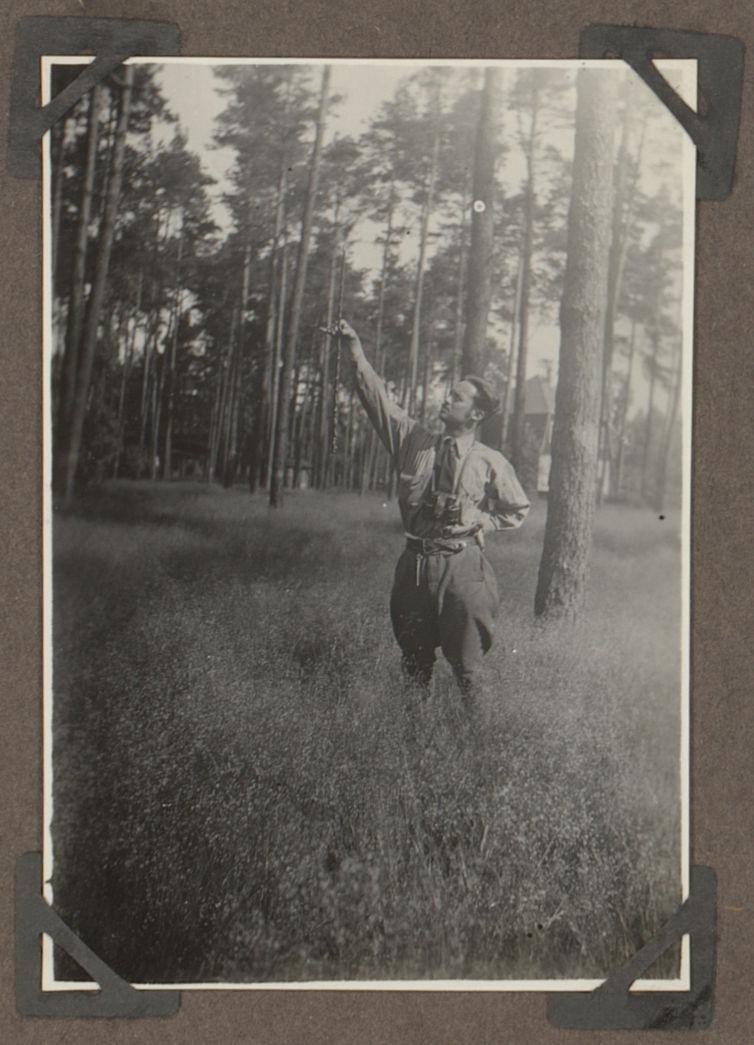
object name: album leaf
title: Johannes van Zijll de Jong in een bos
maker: Anonymous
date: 1930-1935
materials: paper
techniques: gelatin silver print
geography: netherlands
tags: adult man, forest, wood, netherlands